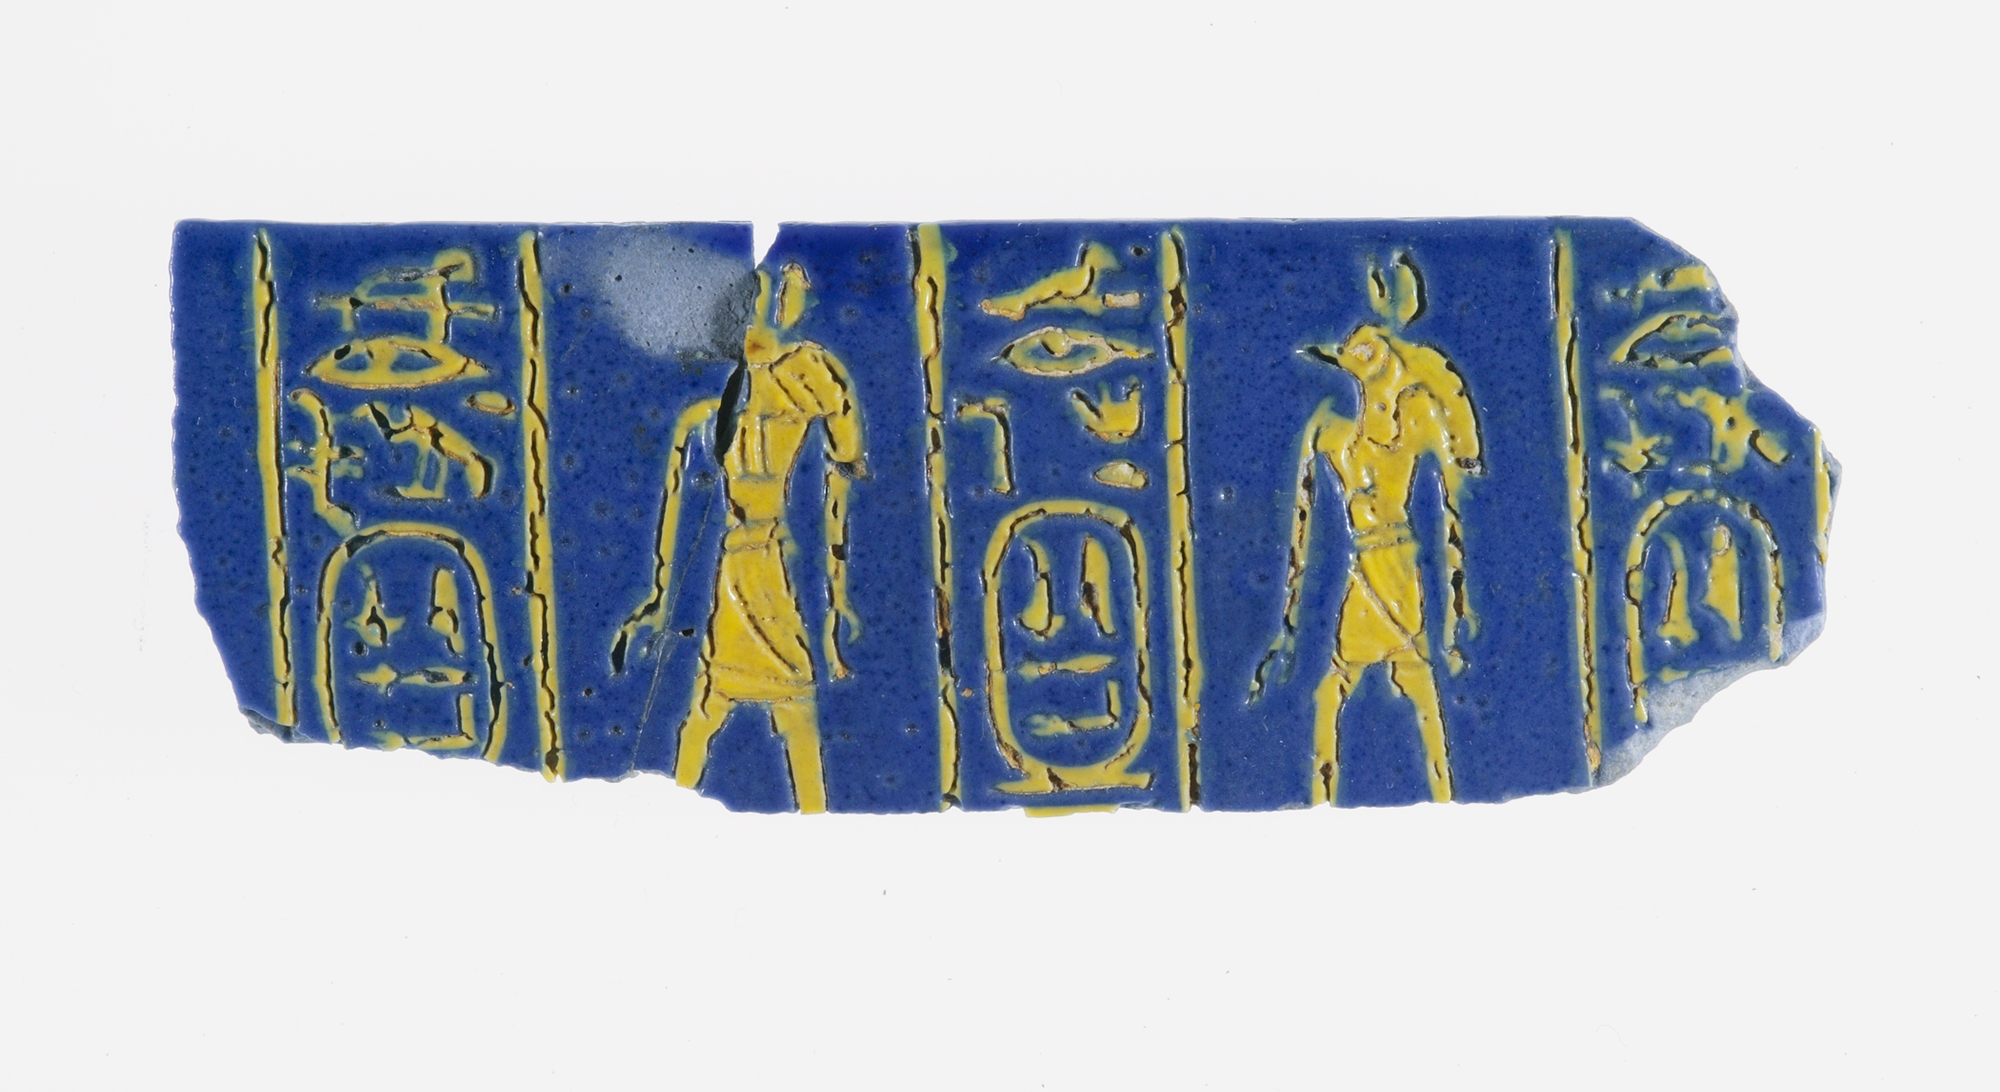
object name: shabti coffin fragment, queen tiaa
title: Shabti coffin fragment of Queen TIaa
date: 1400-1390 BCE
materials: faience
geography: egypt